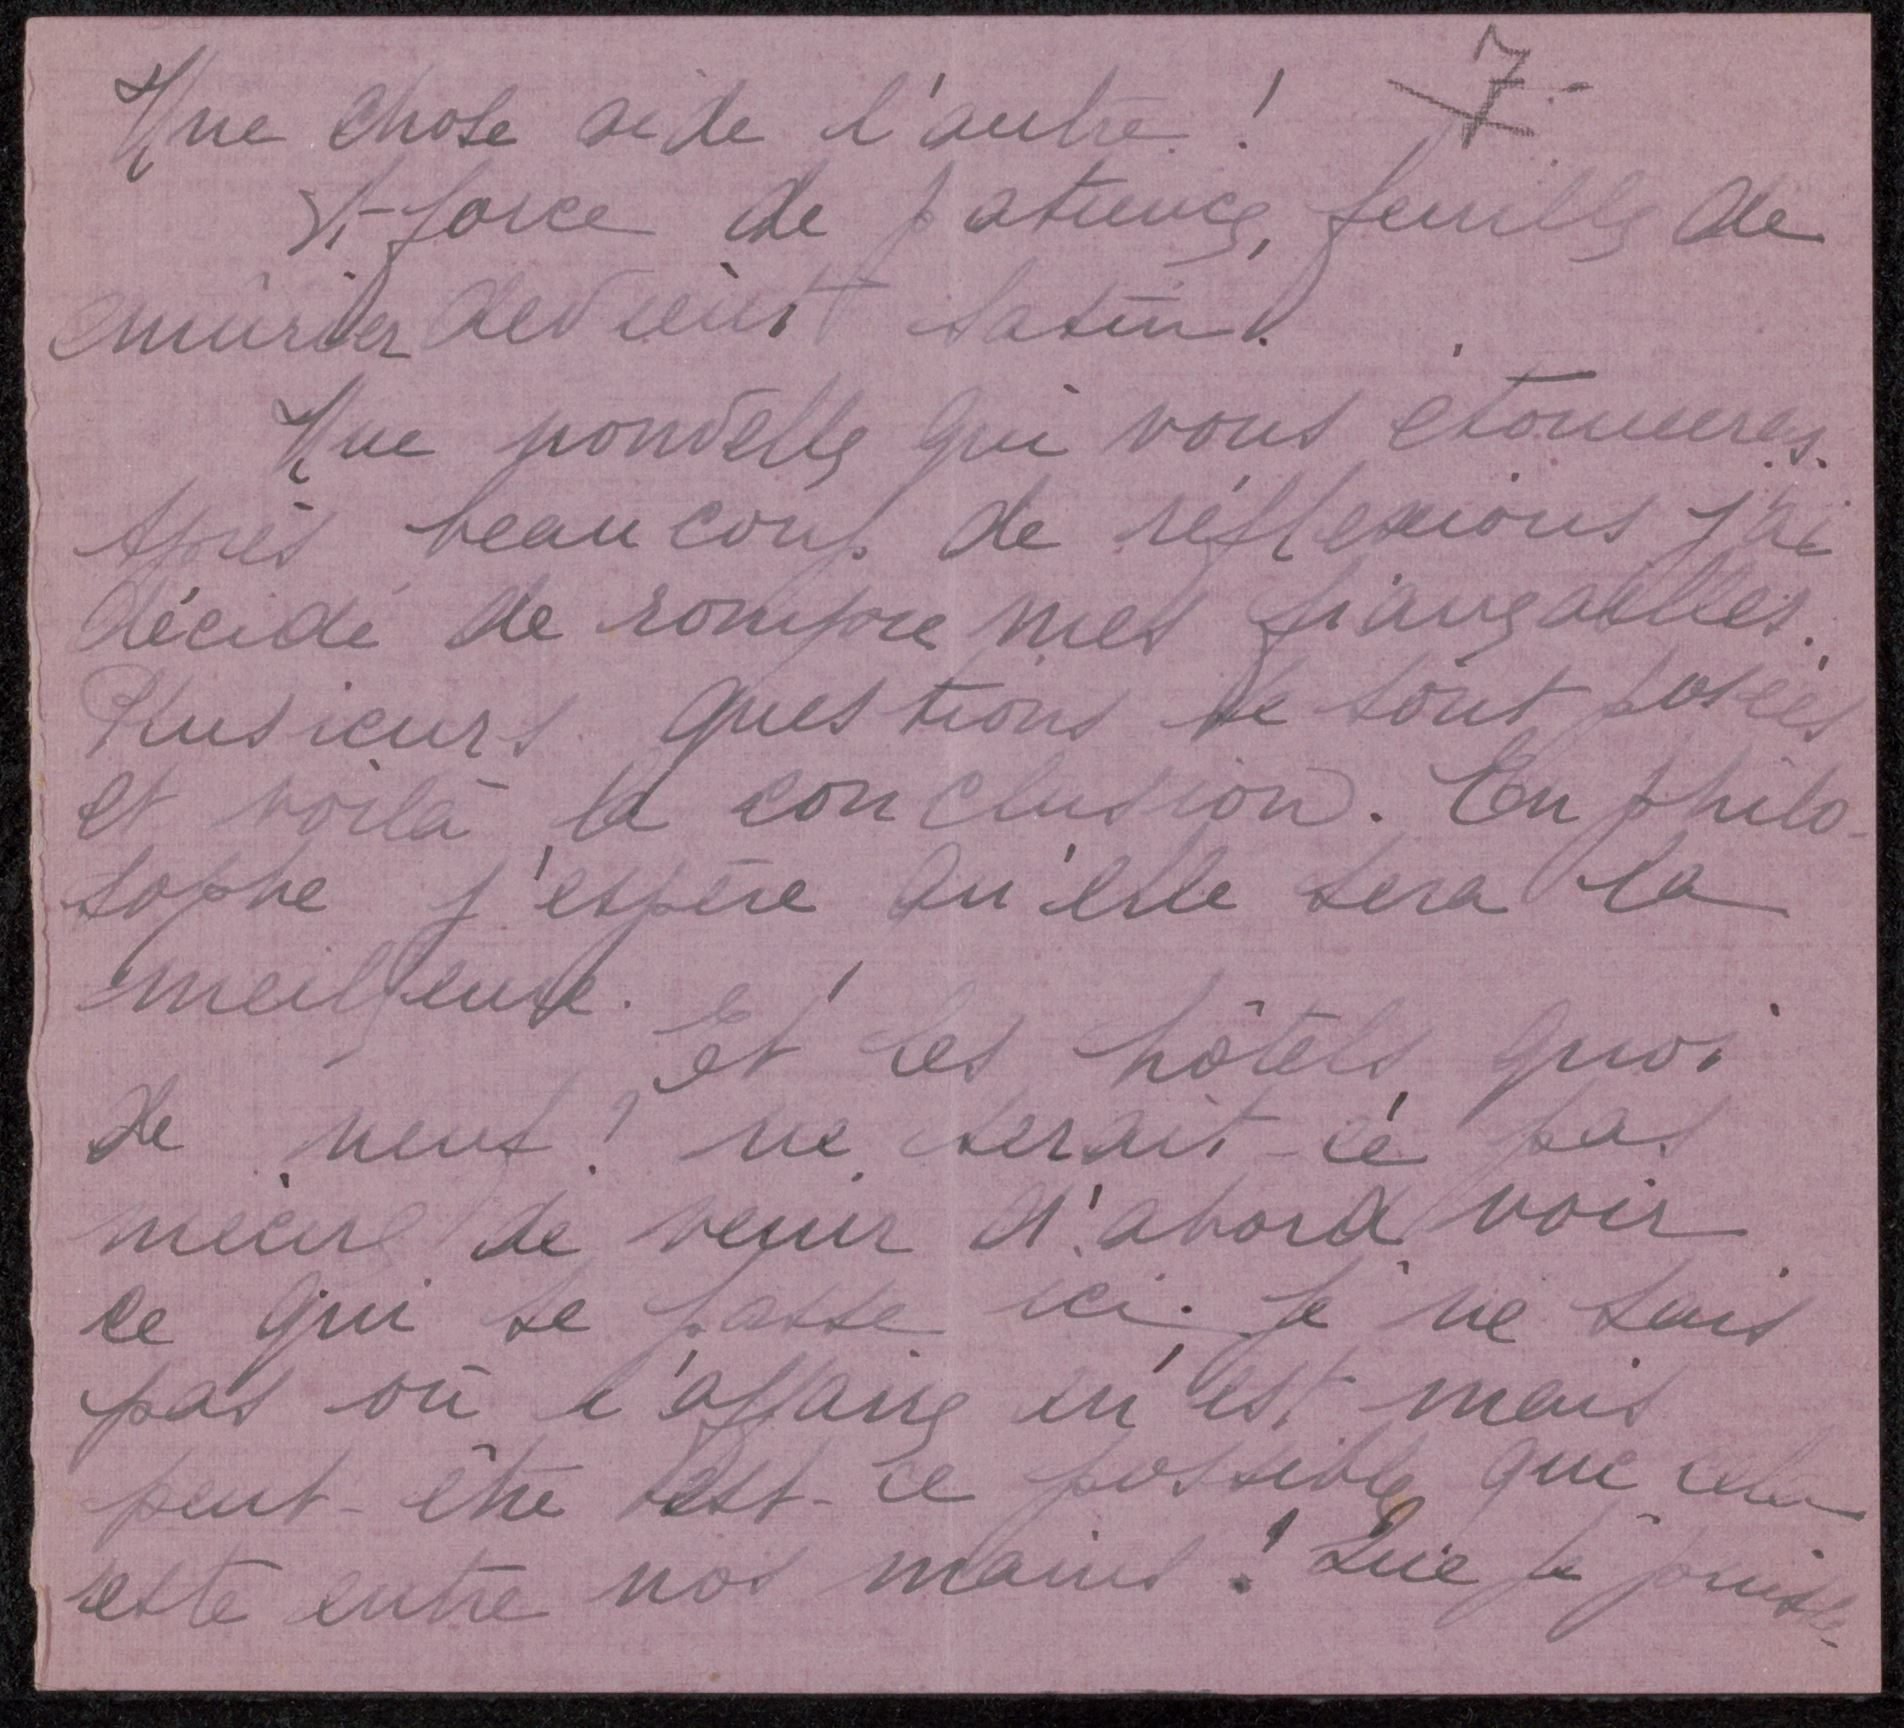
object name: letter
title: Brief aan Philip Zilcken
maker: rose imel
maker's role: draughtsman, painter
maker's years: 1901-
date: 1919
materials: ink, paper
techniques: pen, writing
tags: paris, print maker, sculptor, théophile alexandre steinlen, léonce bénédite, the hague, painter, draughtsman, philip zilcken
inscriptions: collector's mark: ‘RPK’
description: RP-D-1982-43-HIMELSCHEIN-29A vormt samen met RP-D-1982-43-HIMELSCHEIN-29B en RP-D-1982-43-HIMELSCHEIN-29C een doorlopende brief.